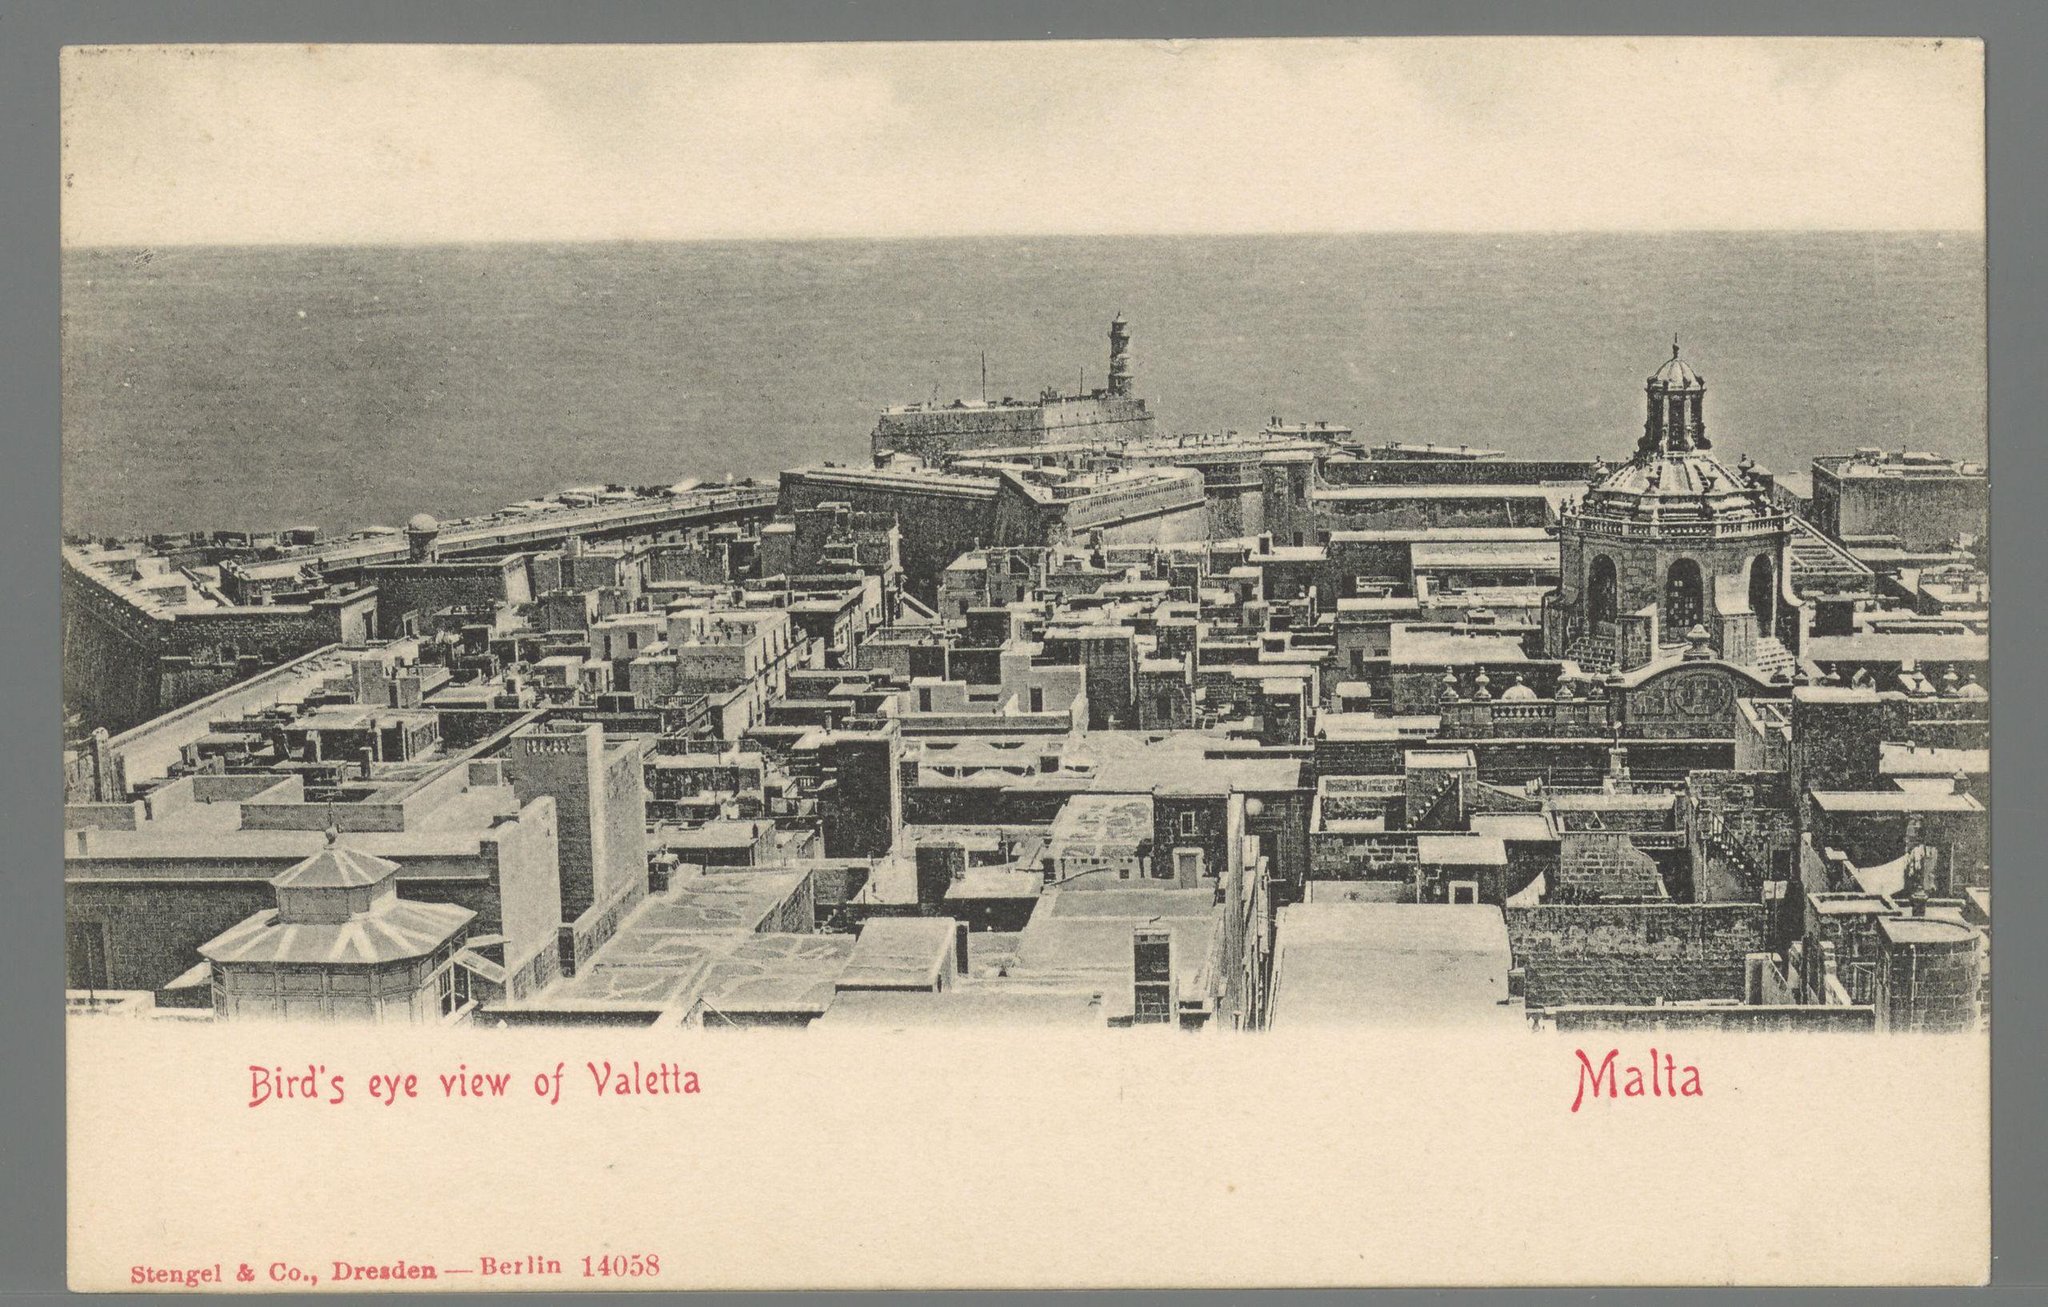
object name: photomechanical print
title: Bird's eye view of Valetta. Malta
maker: Anonymous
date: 1889-1903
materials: cardboard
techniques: photograph, writing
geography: malta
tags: city-view, and landscape with man-made constructions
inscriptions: poststempel, verso, gestempeld